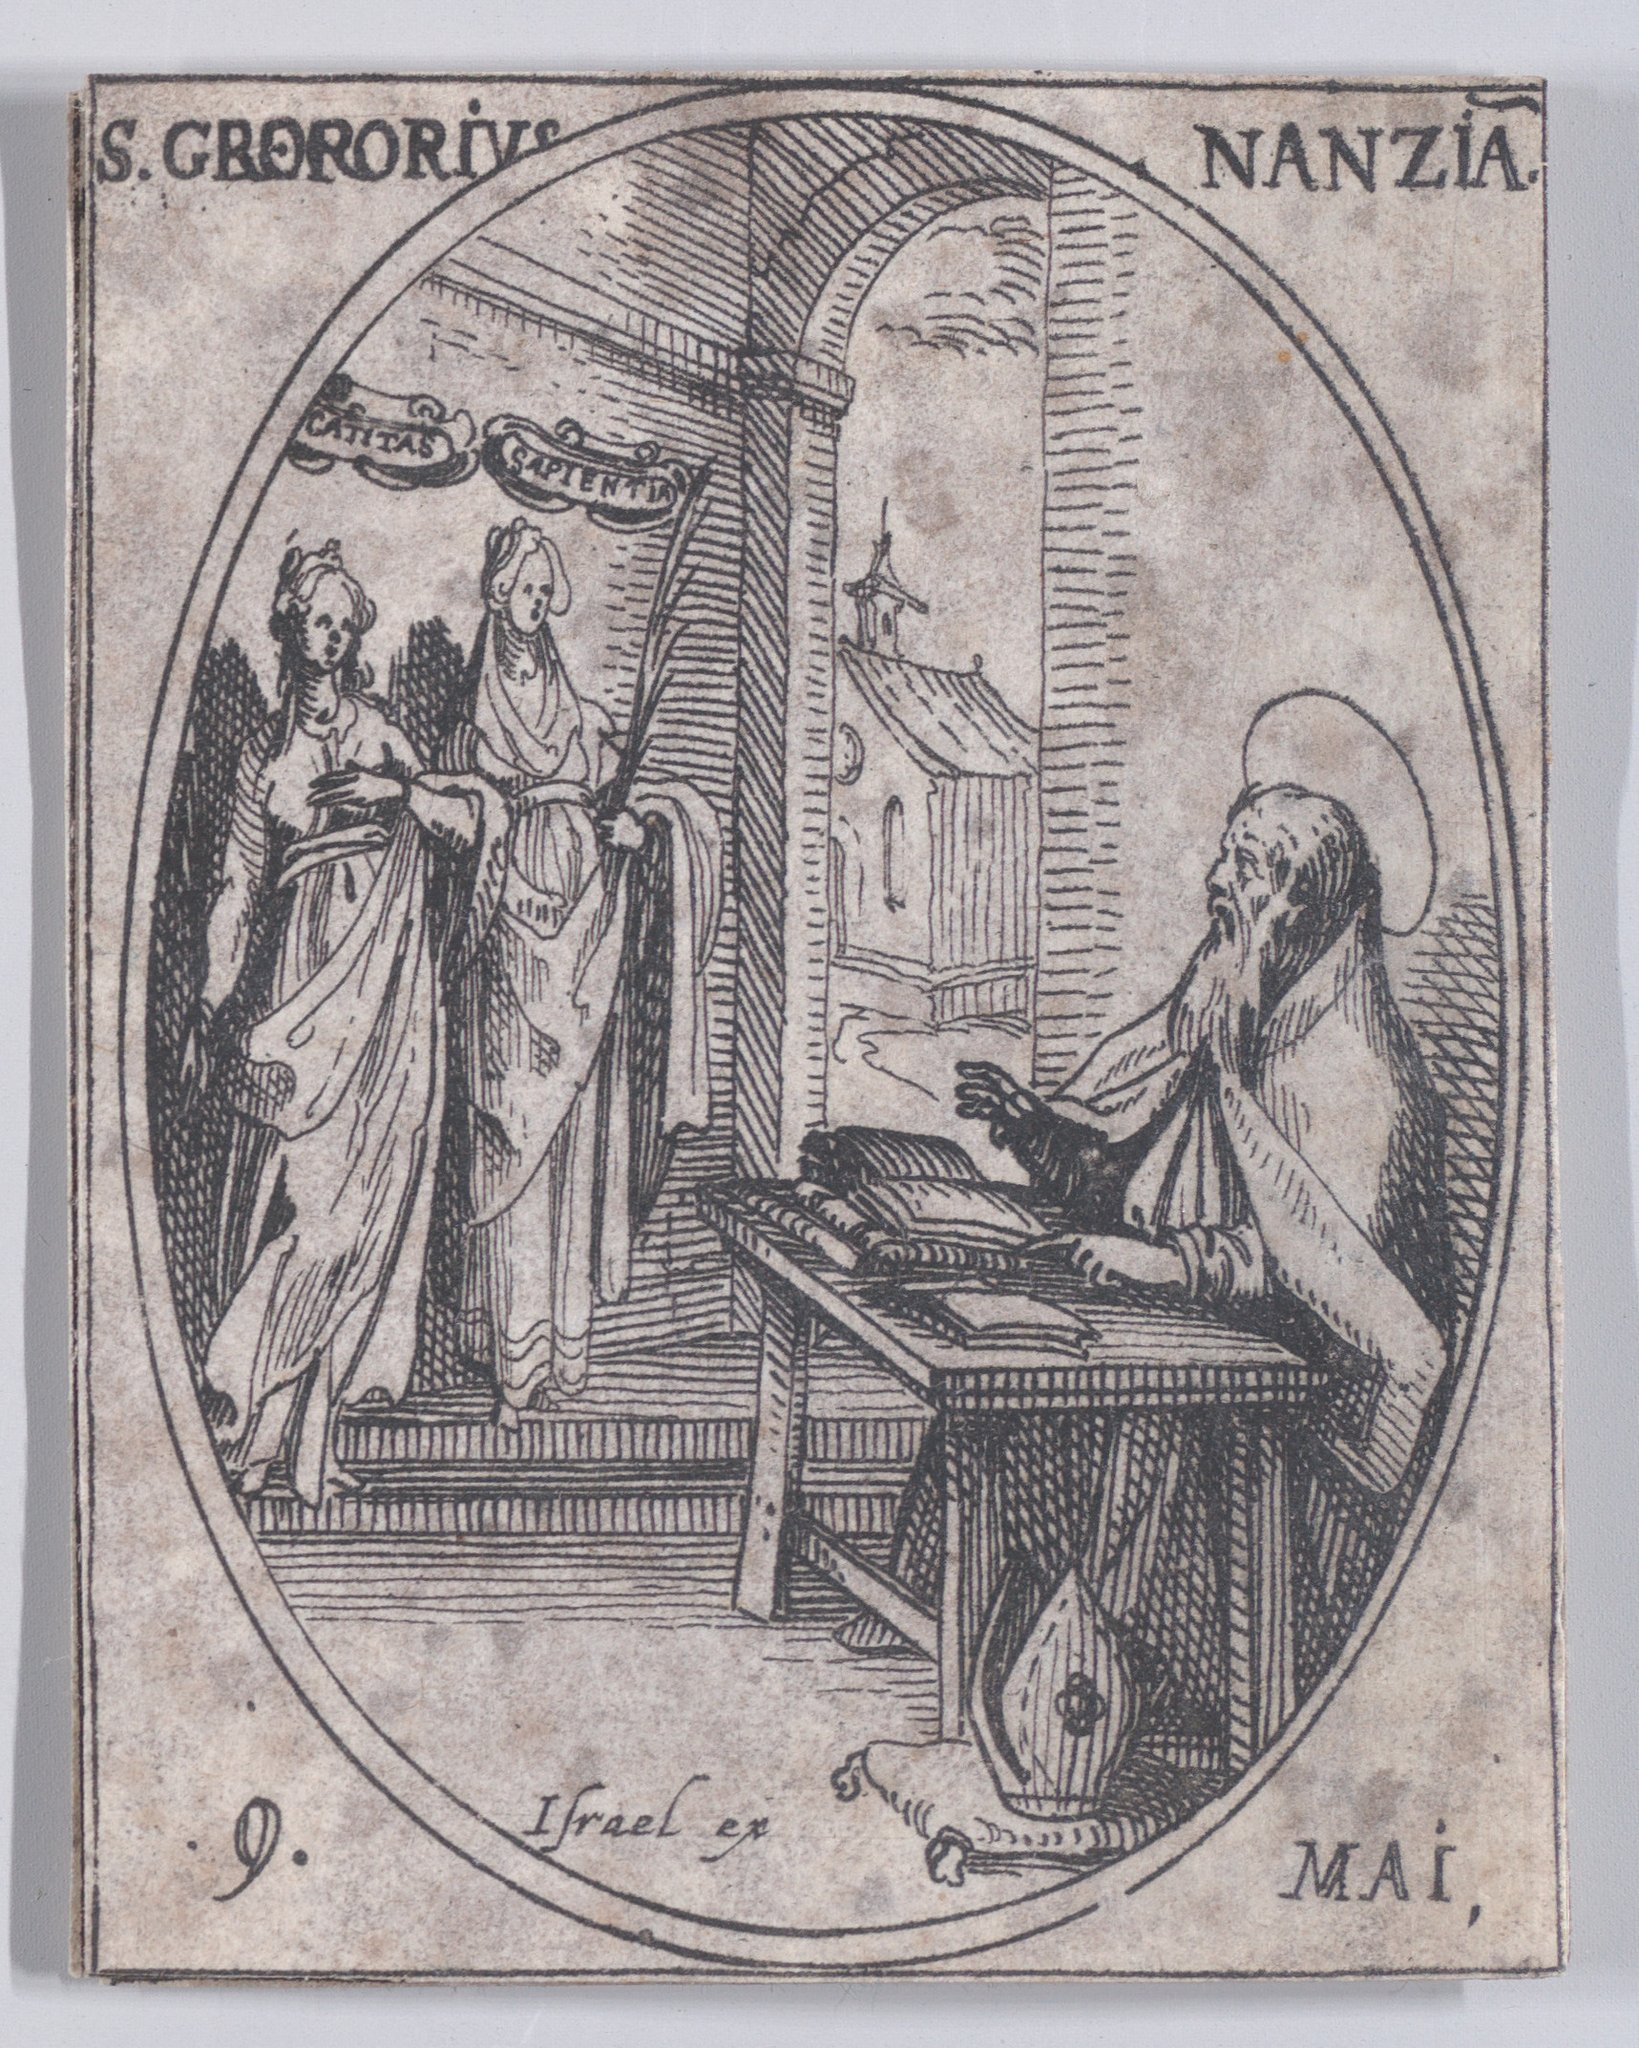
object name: print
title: S. Grégoire de Naziance (St. Gregory of Naziance), May 9th, from "Les Images De Tous Les Saincts et Saintes de L'Année" (Images of All of the Saints and Religious Events of the Year)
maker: jacques callot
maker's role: artist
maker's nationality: french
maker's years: 1592-1635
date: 1636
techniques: etching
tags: men,saints